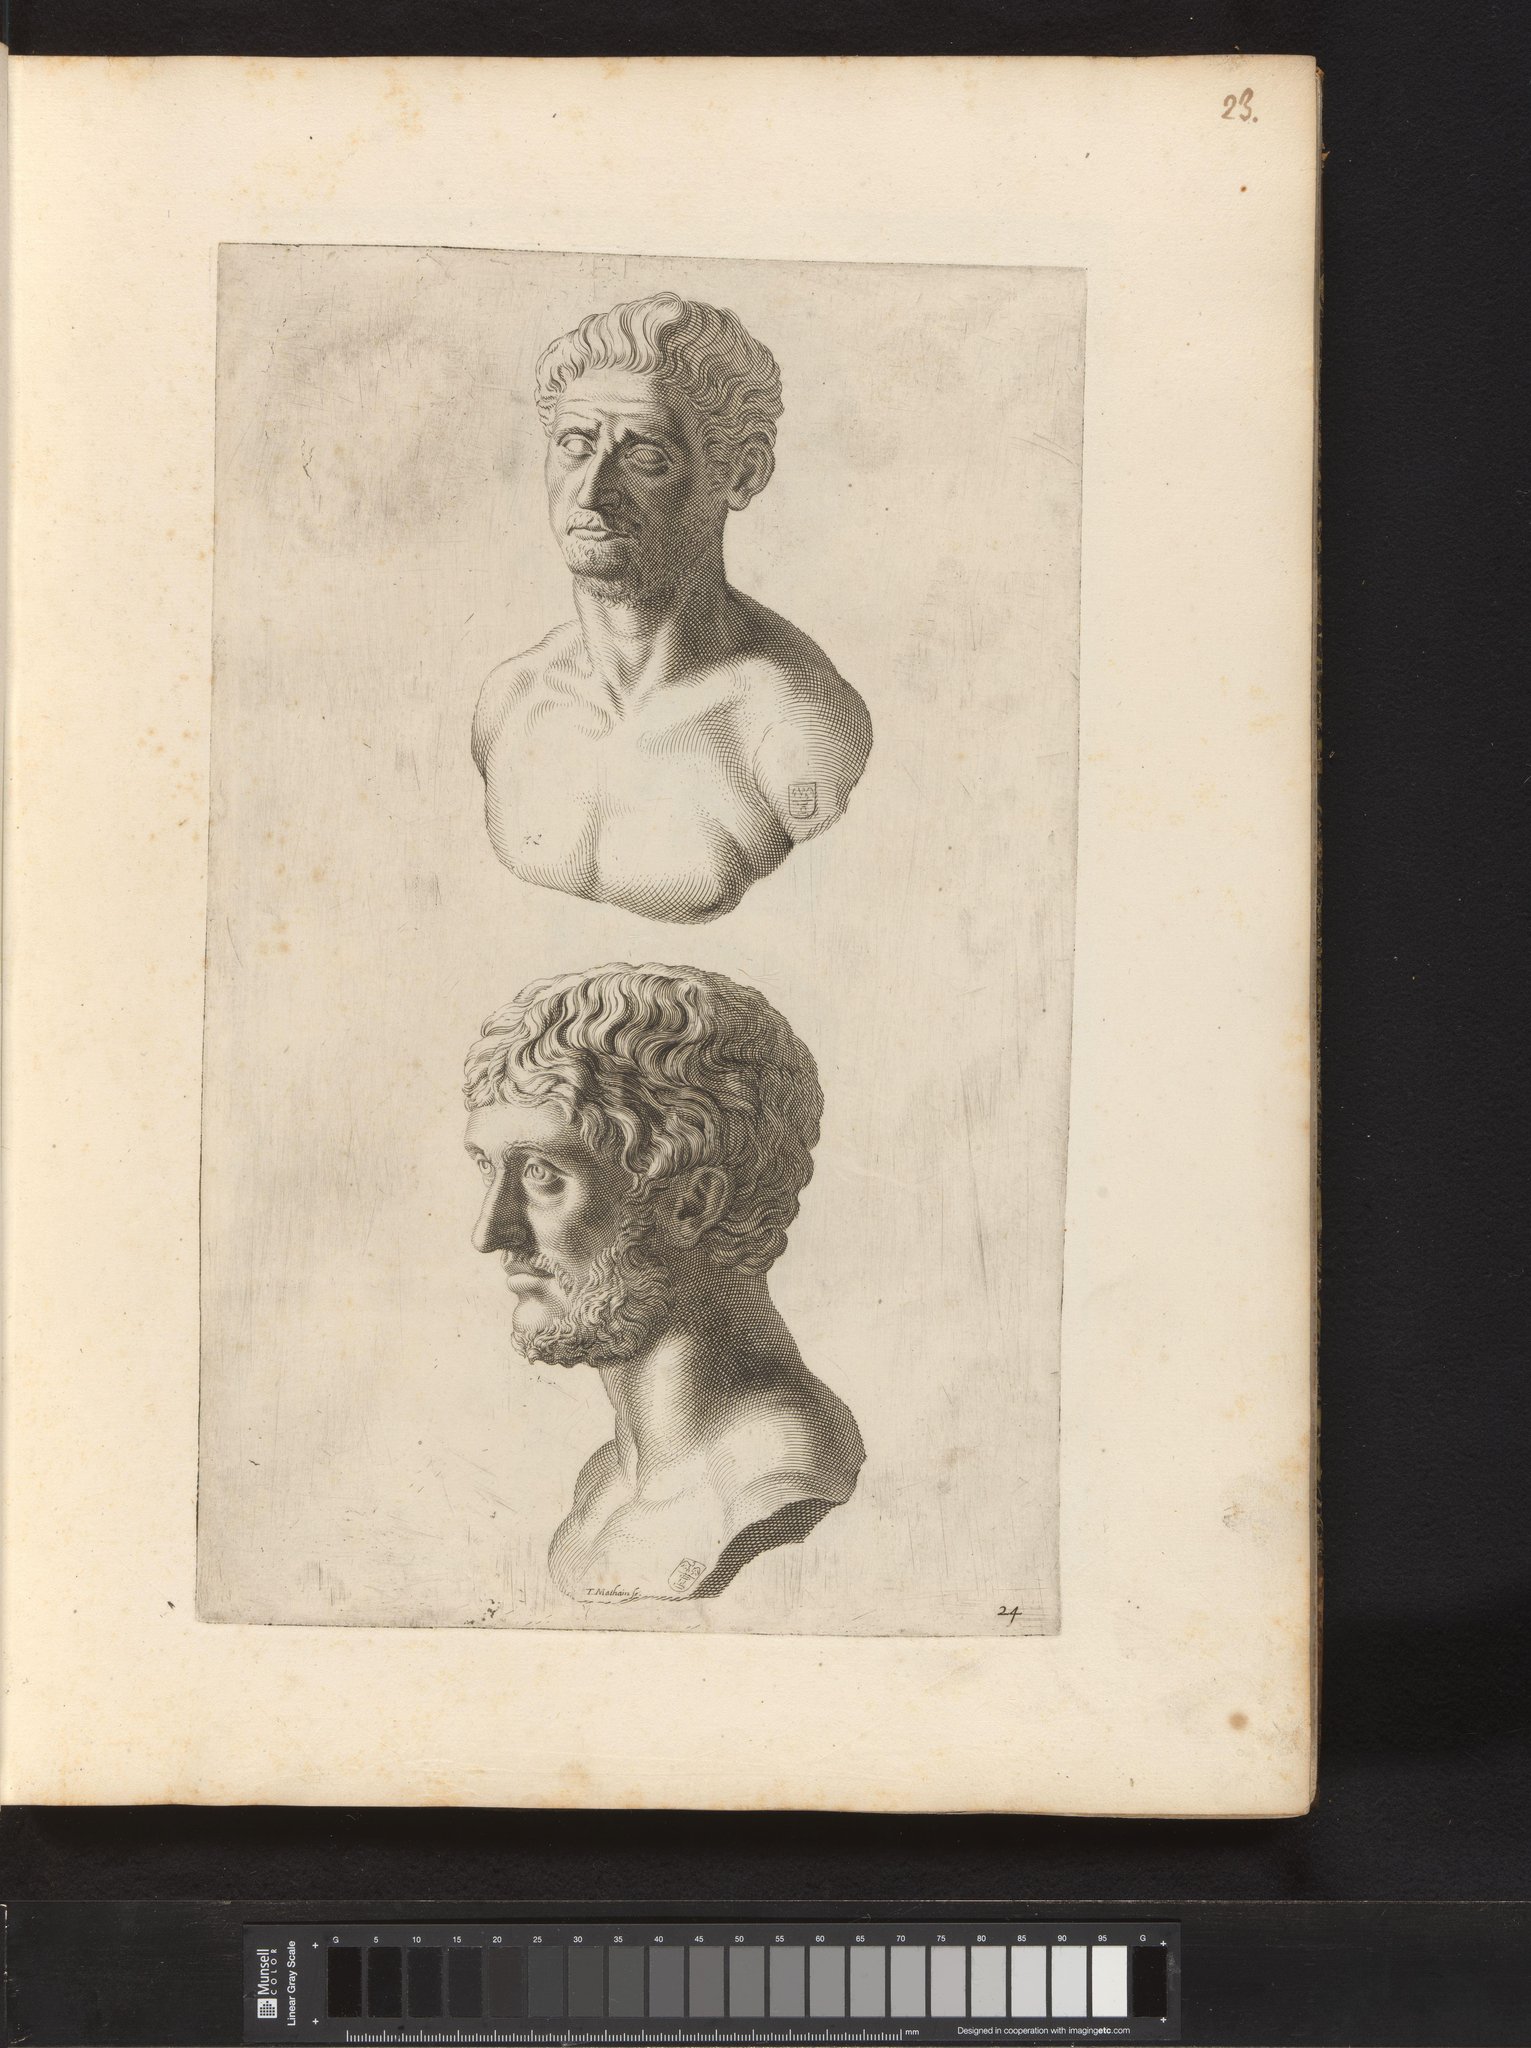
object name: print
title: Galleria Giustiniana del Marchese Vincenzo Giustiniani II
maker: theodor matham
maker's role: draughtsman, print maker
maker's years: 1605-1676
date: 1636-1647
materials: paper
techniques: engraving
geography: rome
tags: male persons from classical history (+ head, bust, etc.), piece of sculpture, reproduction of a piece of sculpture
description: Twee portretbustes van Romeinse keizers. Op beide bustes het wapenschild van Vincenzo Giustiniani. Prent maakt deel uit van een album met een serie prenten naar de sculpturen in de verzameling in de Galleria Giustiniani te Rome.